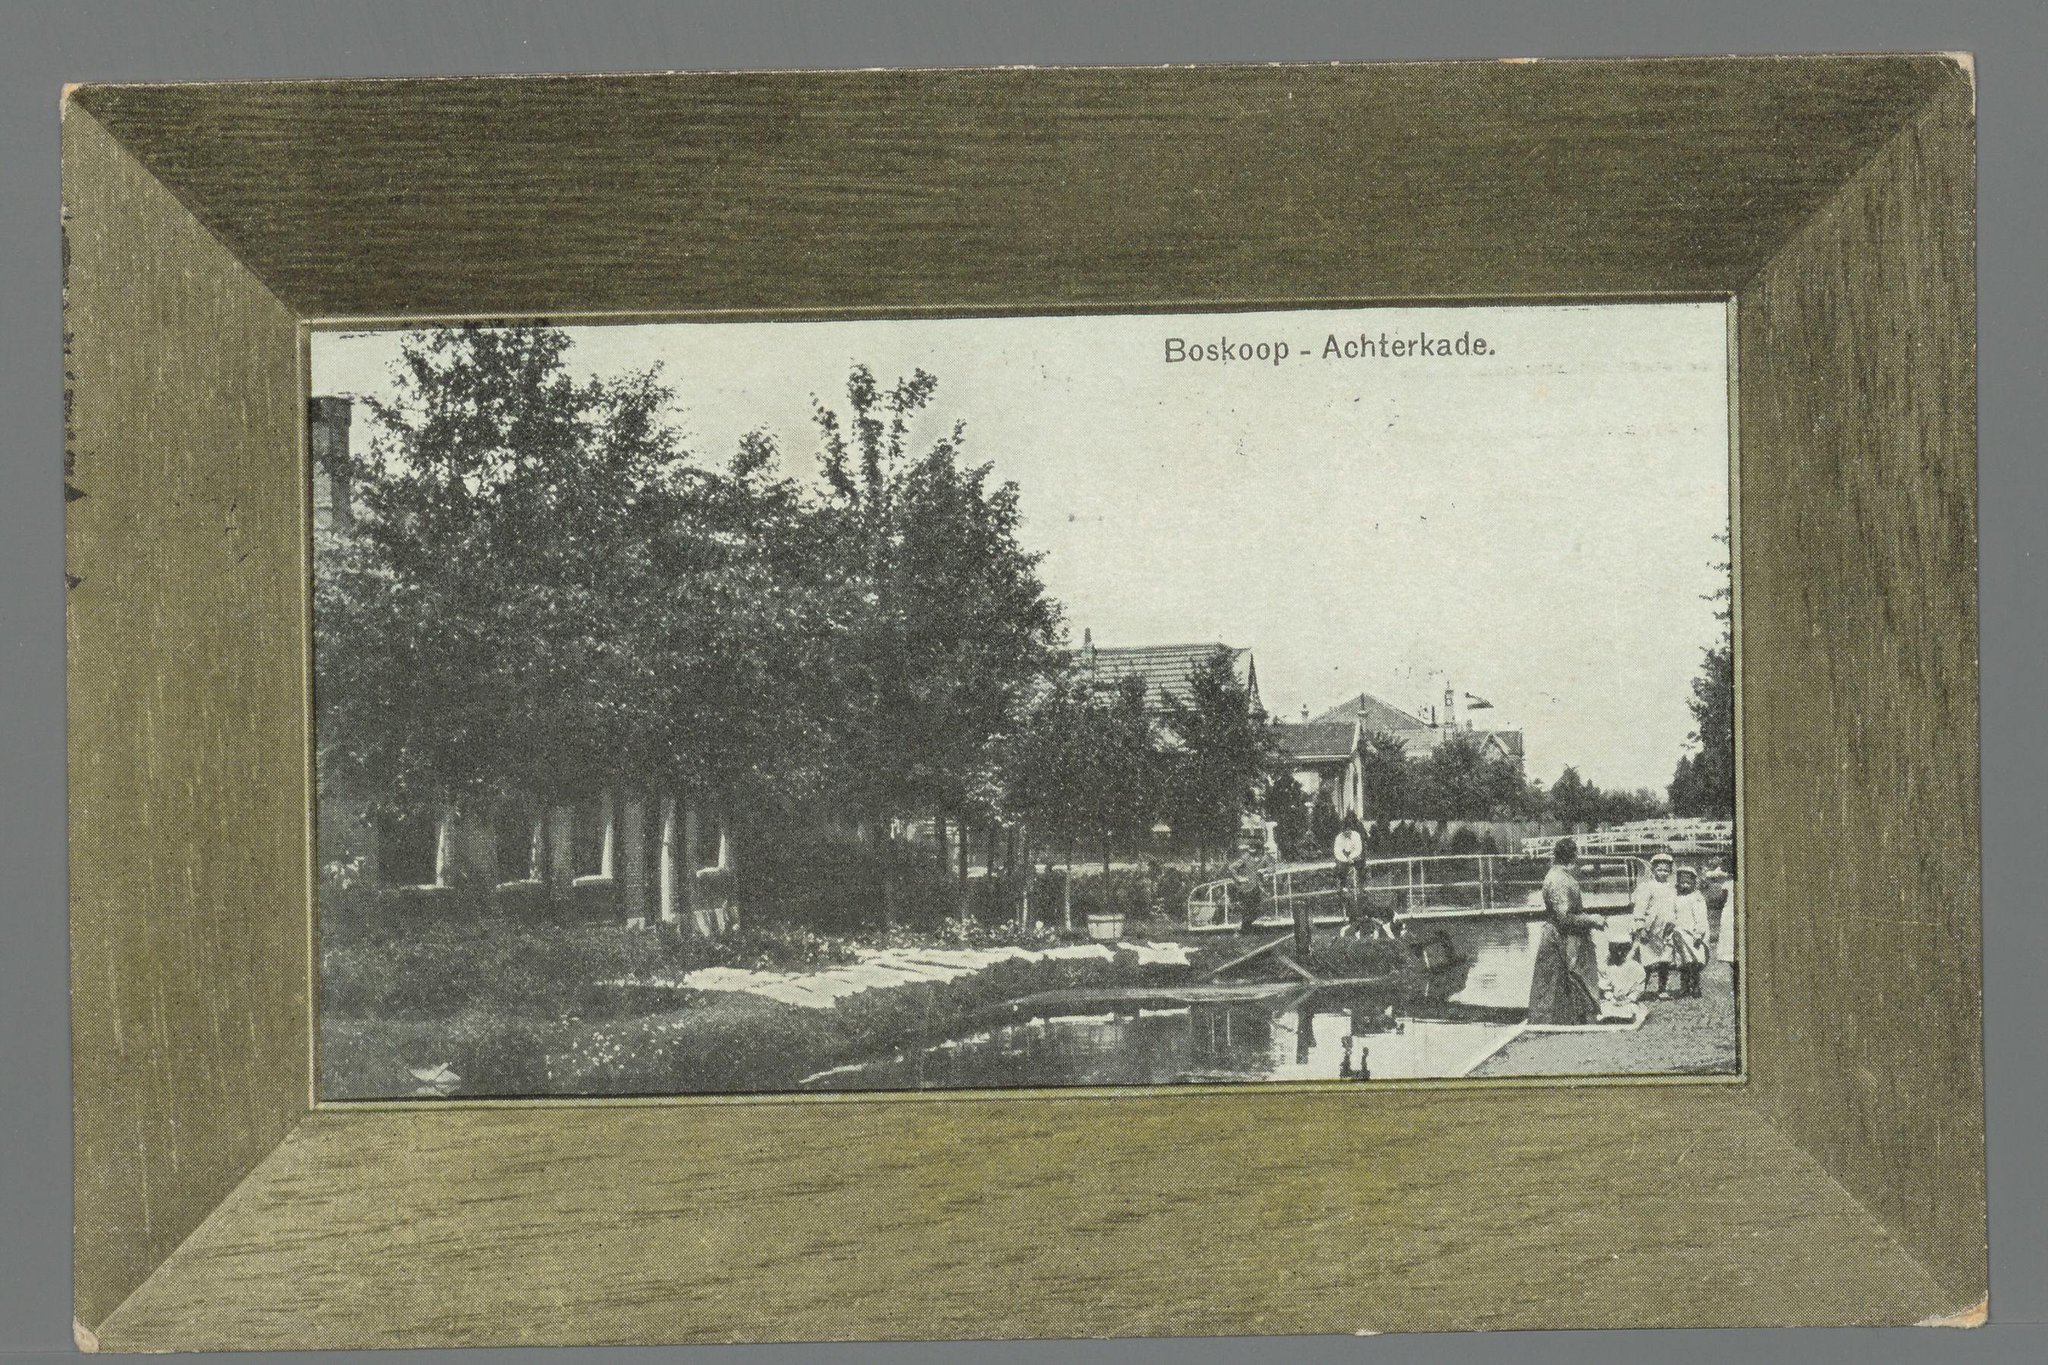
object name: photomechanical print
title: Boskoop - Achterkade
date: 1892-1911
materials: cardboard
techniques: lithograph, writing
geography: boskoop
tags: city-view, and landscape with man-made constructions, canals, waters (in city), bridge in city across river, canal, etc.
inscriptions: postage stamp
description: In achterzijde briefkaart zit een standaard zodat de kaart kan staan.